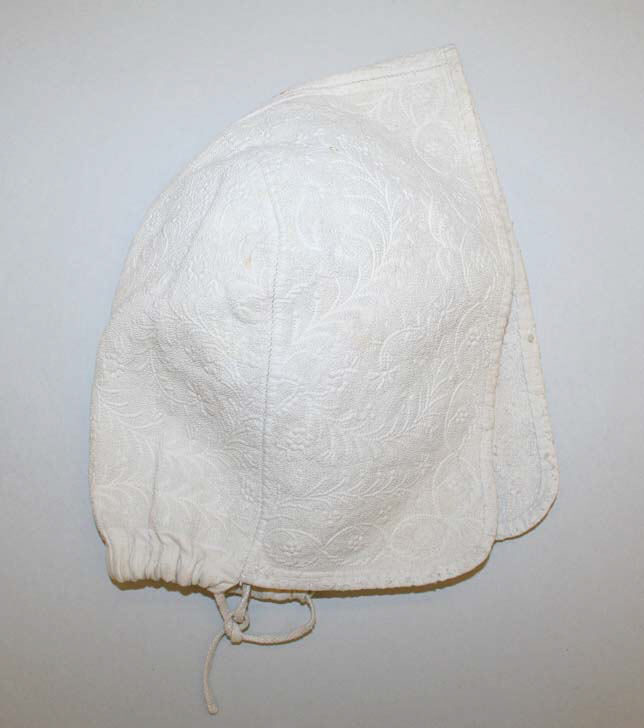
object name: cap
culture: french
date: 1701-1800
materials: linen